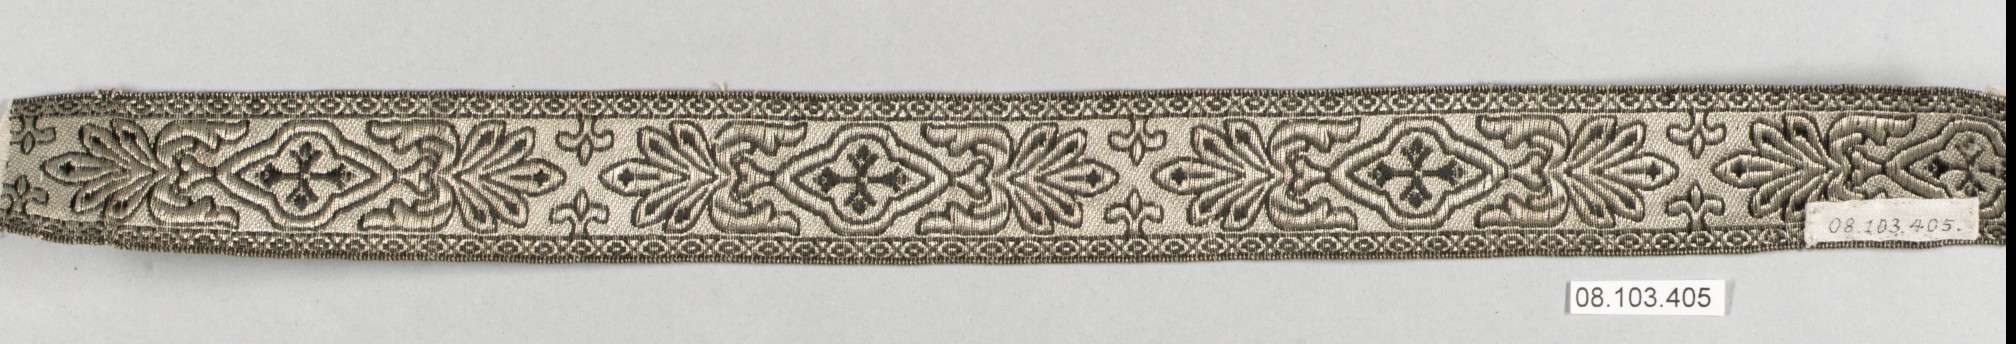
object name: galloon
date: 1701-1900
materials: metal thread